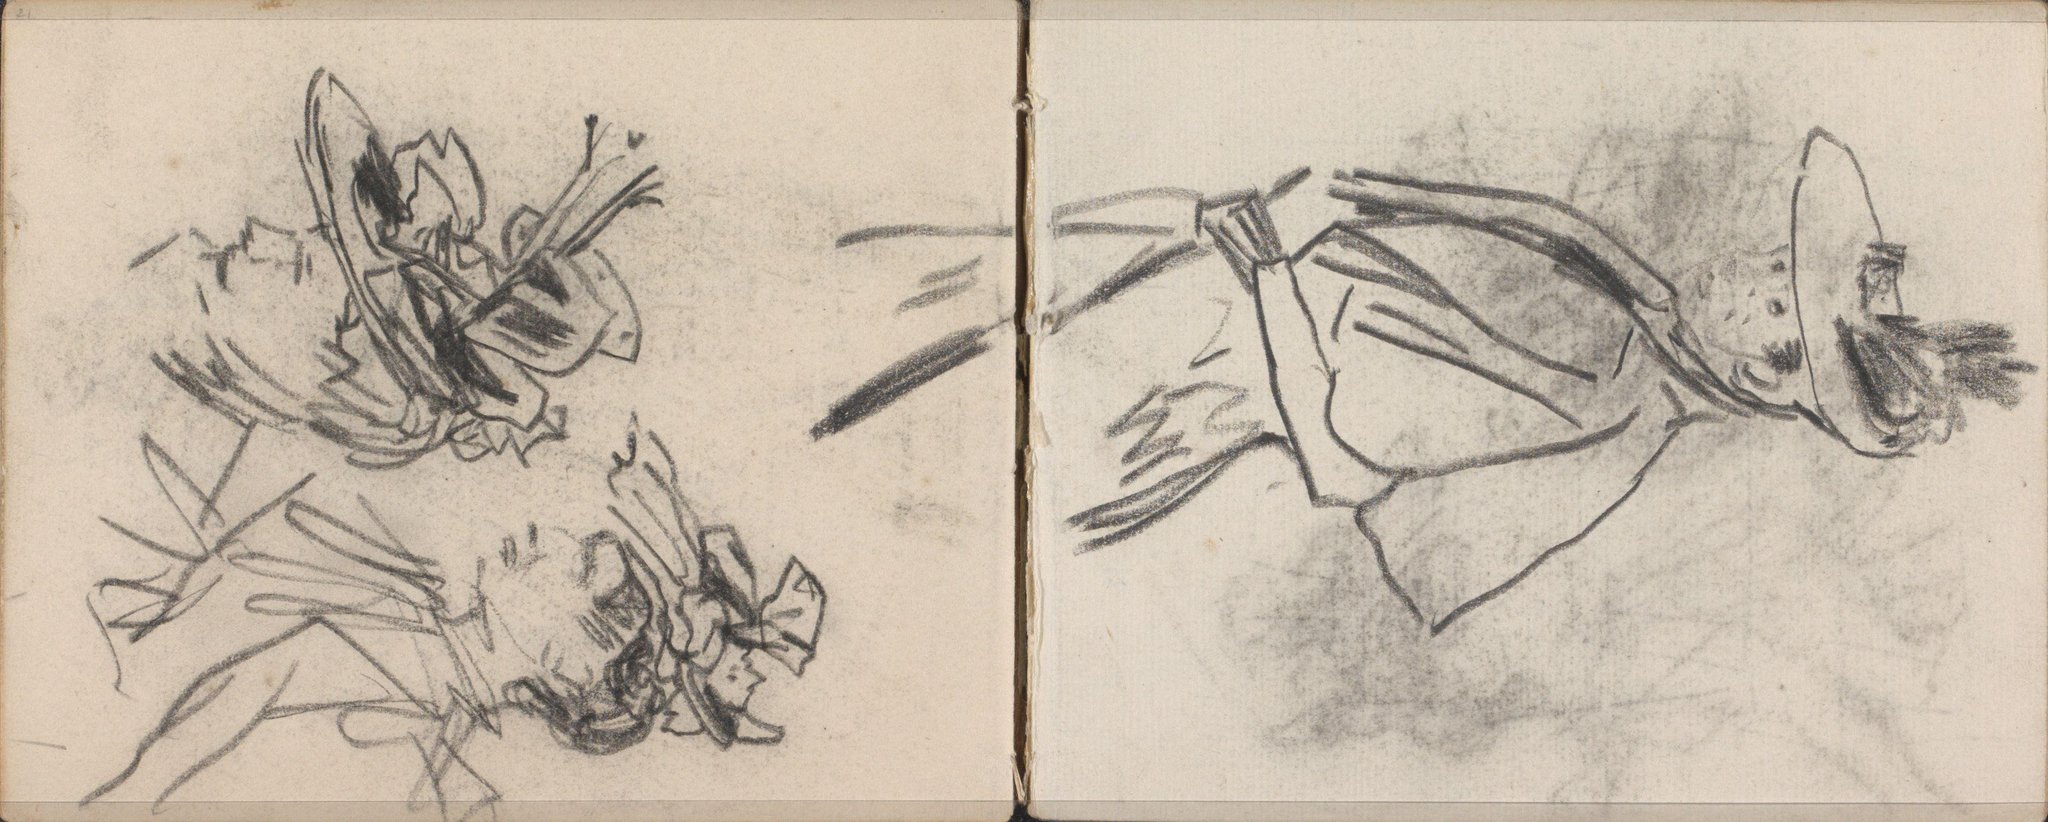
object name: sketchbook leaf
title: Drie vrouwen met hoeden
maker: george hendrik breitner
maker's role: draughtsman, painter, print maker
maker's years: 1857-1923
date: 1886-1891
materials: chalk, paper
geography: amsterdam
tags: adult woman, head-gear: hat (+ women's clothes)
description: Pagina 21 en pagina 22 uit een schetsboek met 32 bladen.